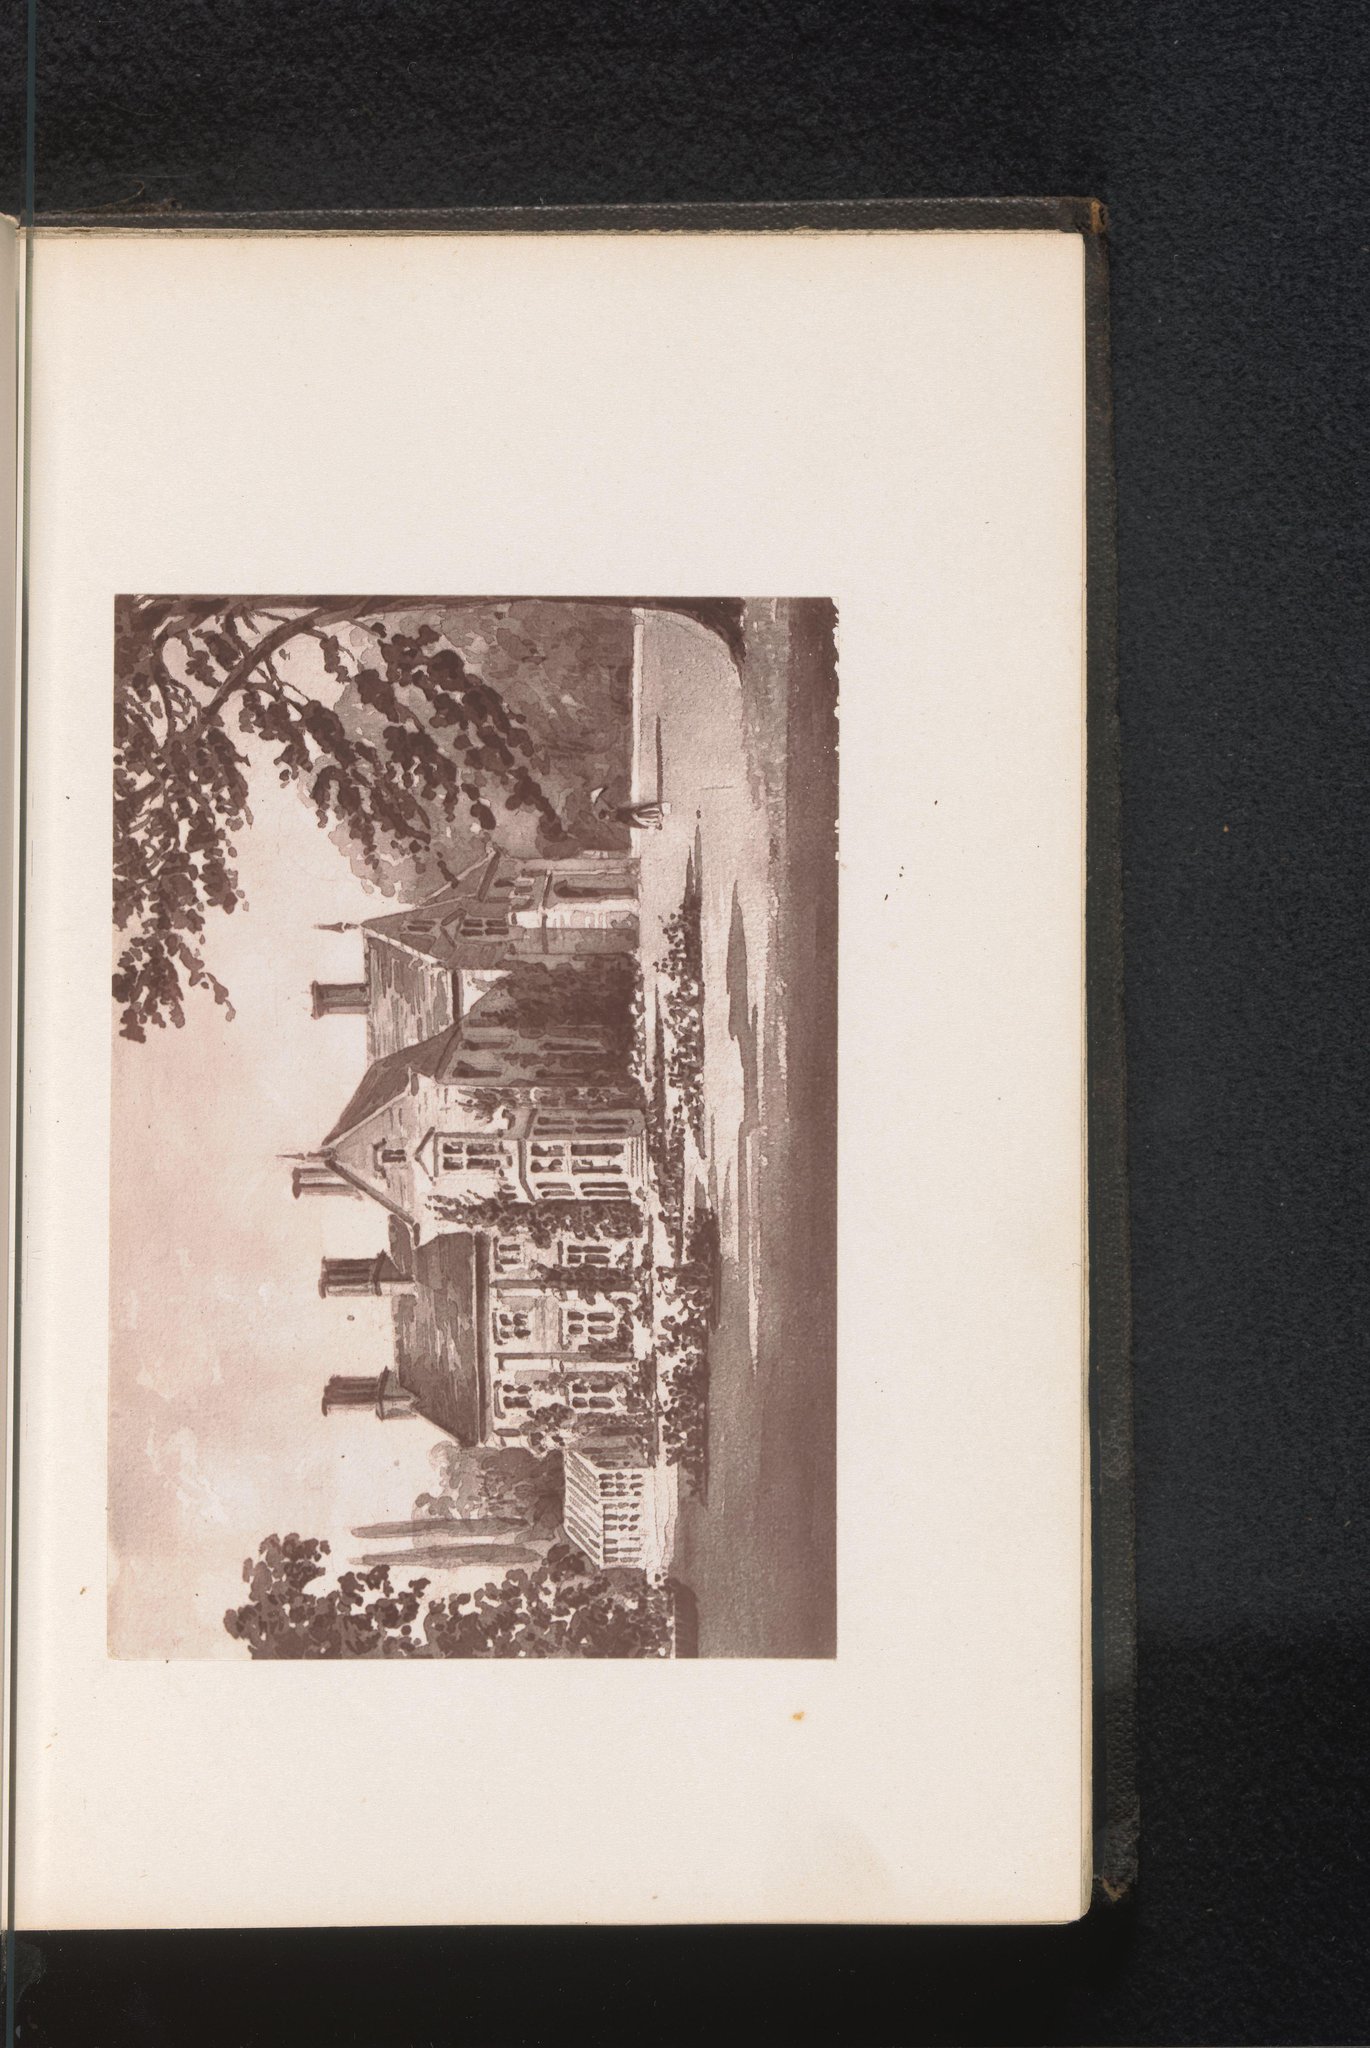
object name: page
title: Fotoreproductie van een schildering, voorstellende een gezicht op de pastorie van Hodnet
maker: Anonymous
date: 1866-1876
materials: paper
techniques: woodburytype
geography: hodnet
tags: the place of worship and its equipment ~ christian churches, façade (of house or building)